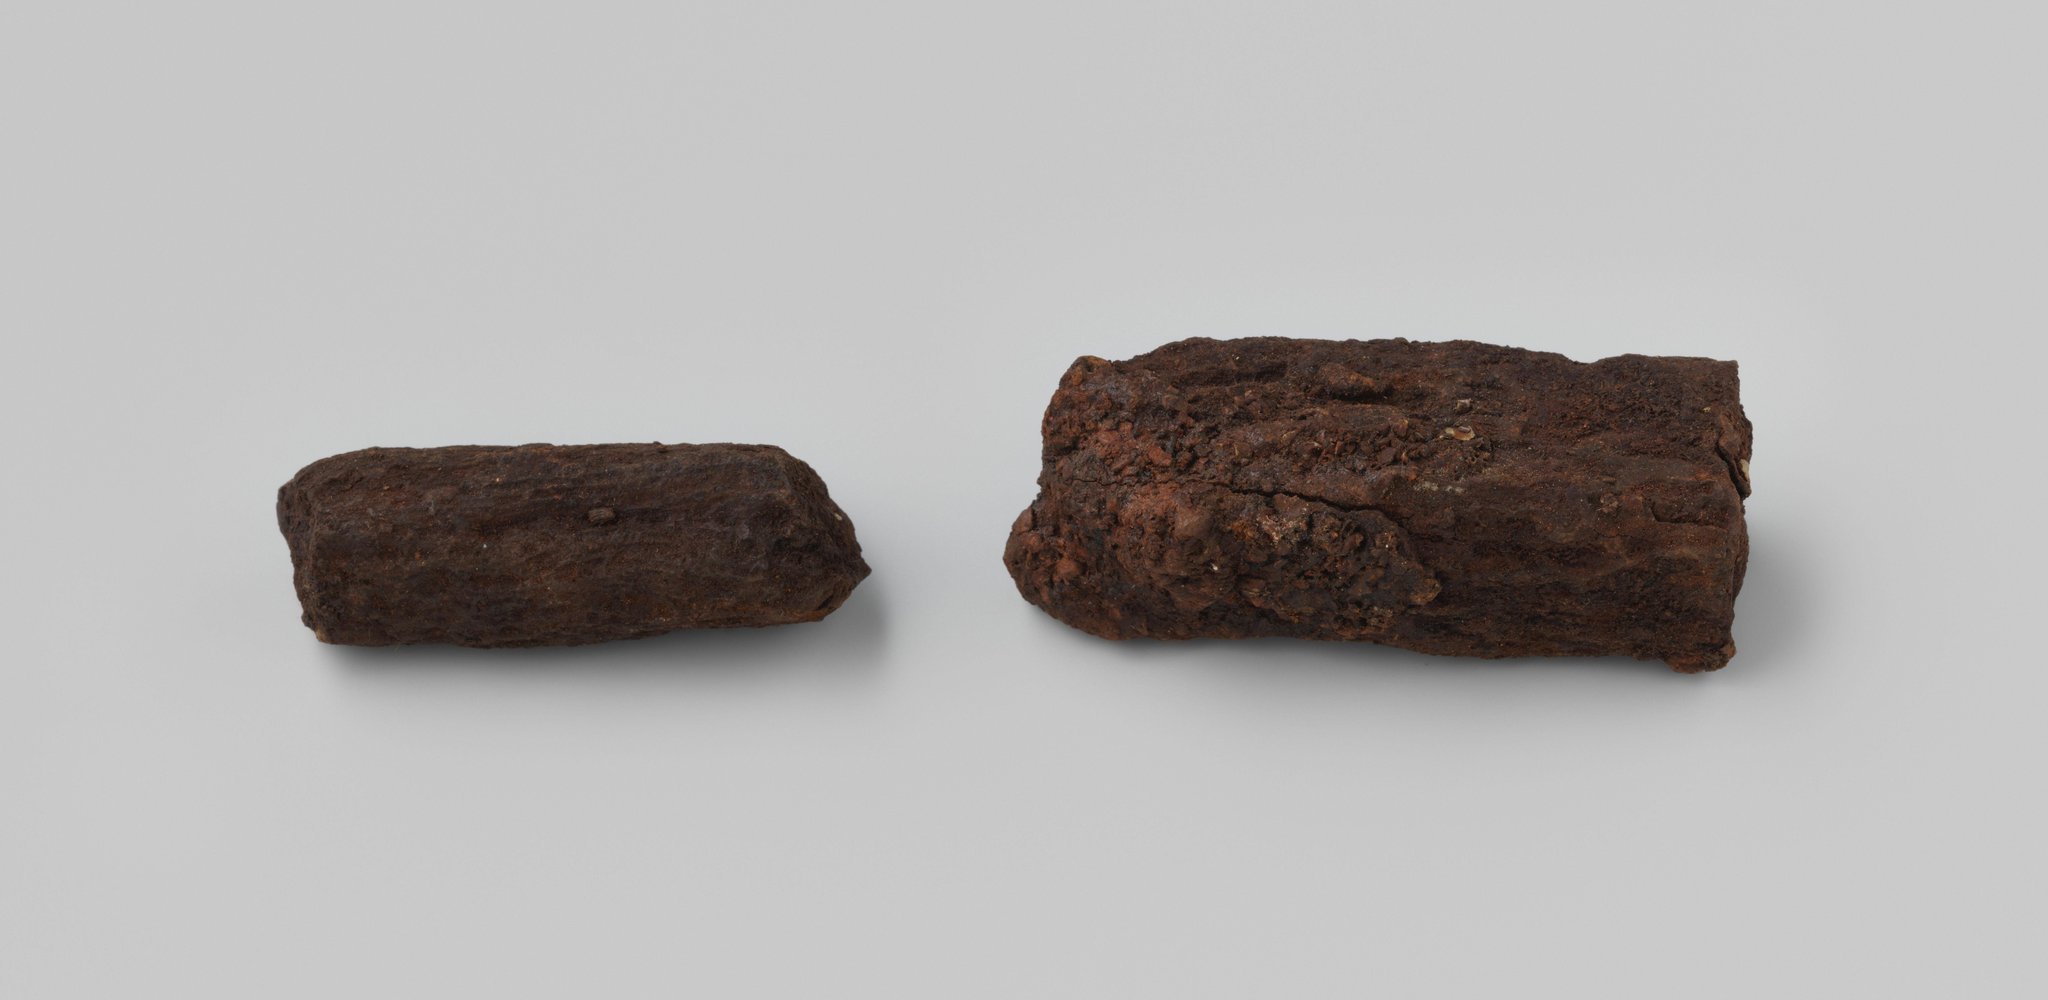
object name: fragment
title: Fragmenten of onderdelen uit het wrak van de Oost-Indiëvaarder Hollandia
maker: Anonymous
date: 1743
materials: iron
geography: netherlands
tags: verenigde oostindische compagnie, hollandia (schip), annet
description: Varied parts or fragments, bar(-shaped) fragments; fragm, heavily eroded, broken.